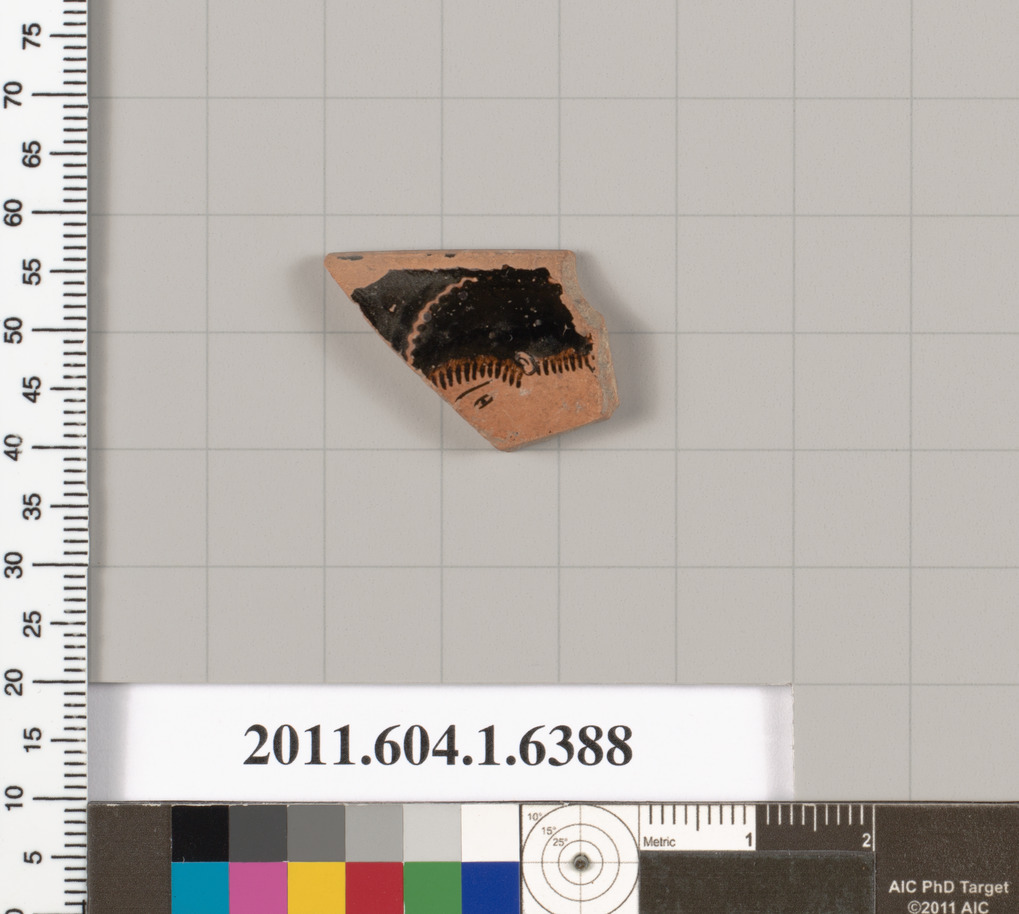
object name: kylix fragment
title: Terracotta rim fragment of a kylix (drinking cup)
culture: greek, attic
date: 490-480 BCE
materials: terracotta